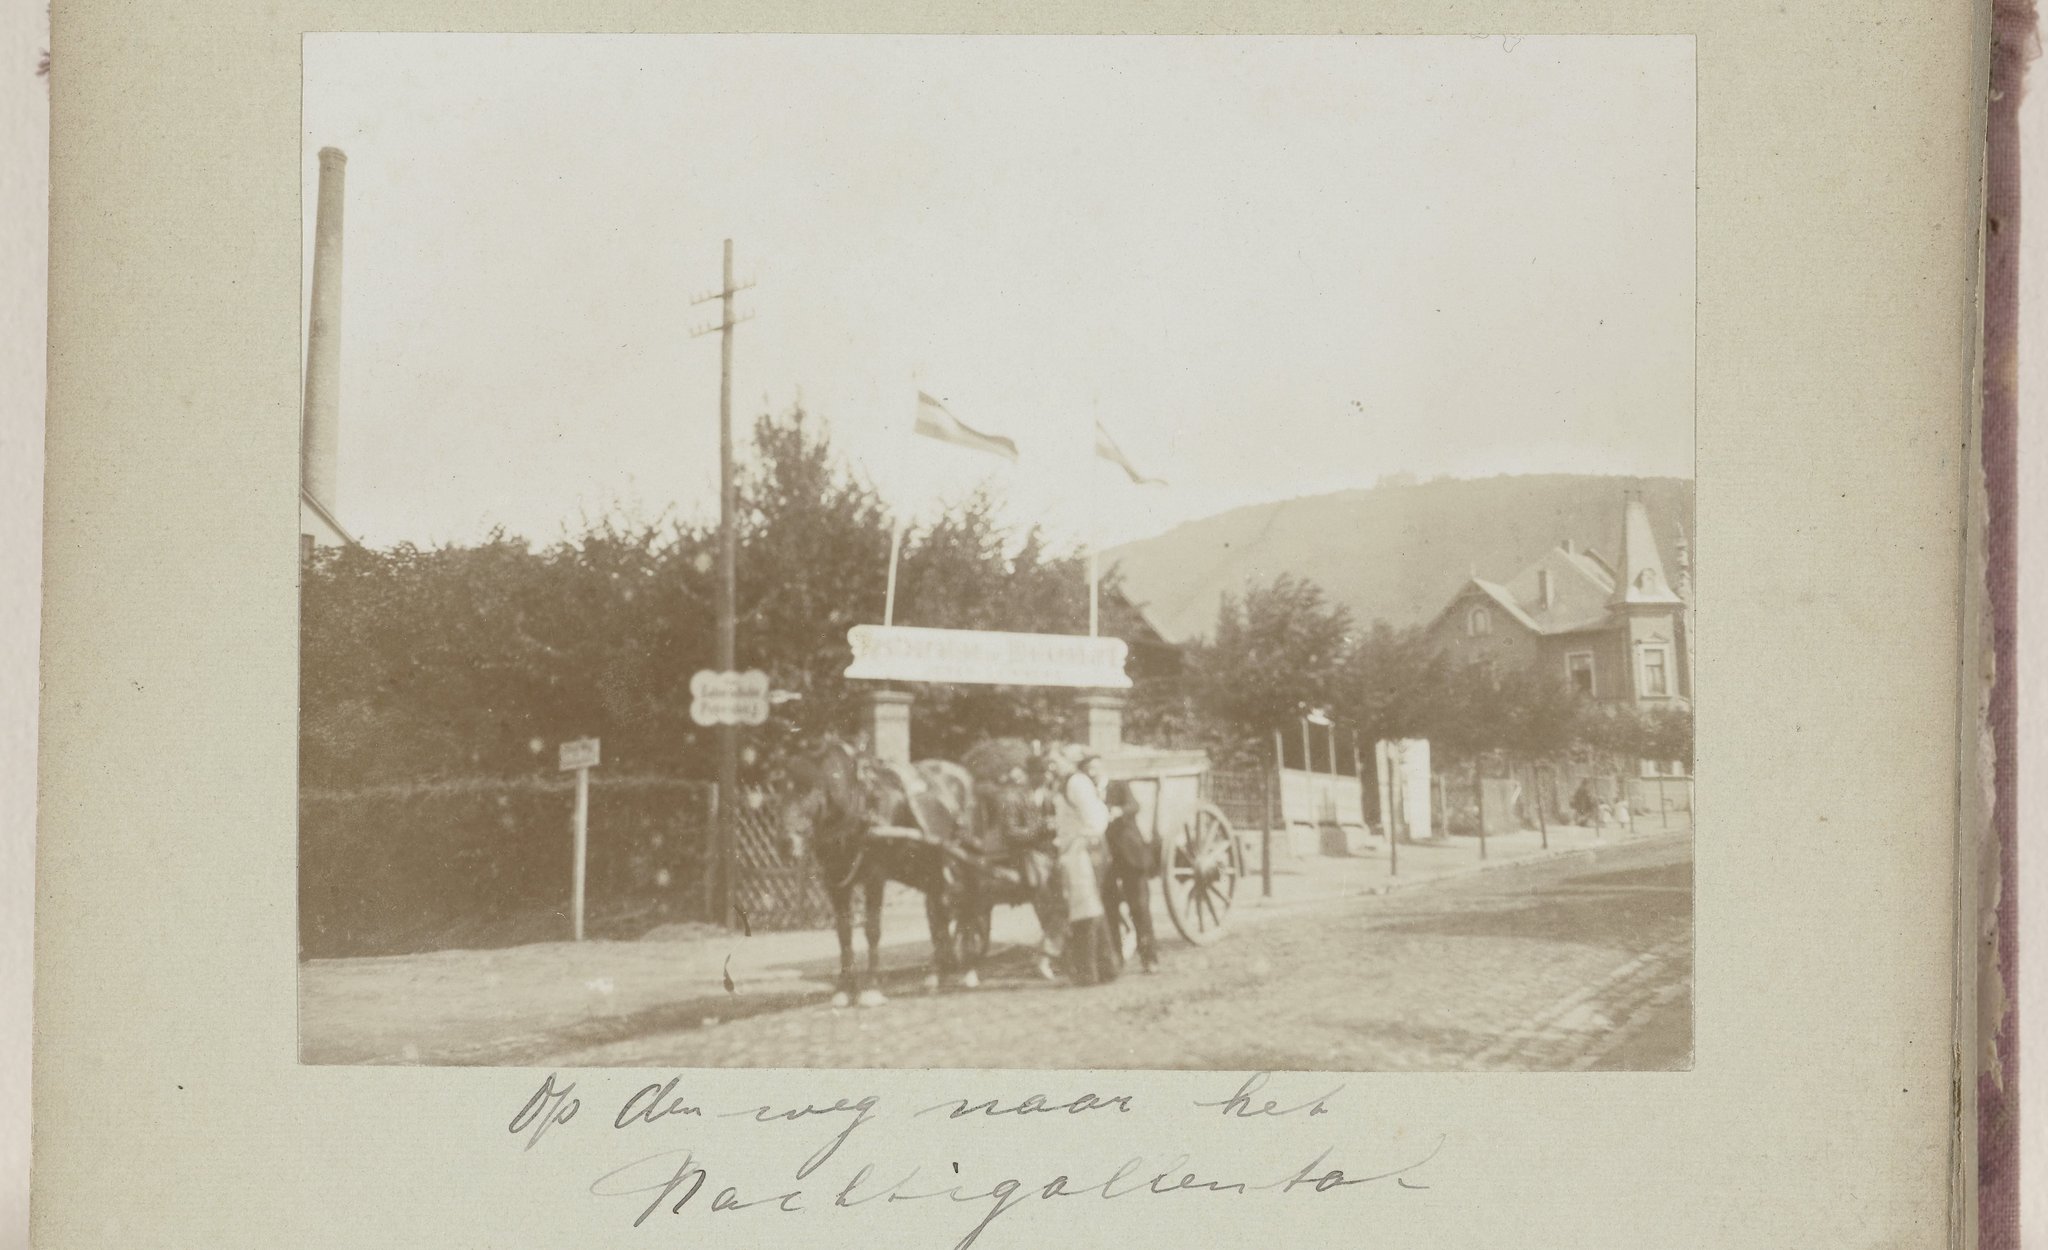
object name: album leaf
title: Straatgezicht met paard-en-wagen, Königswinter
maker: david vermeulen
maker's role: fotograaf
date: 1895-1905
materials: paper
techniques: collodion silver print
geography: königswinter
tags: four-wheeled vehicle drawn by one animal, street